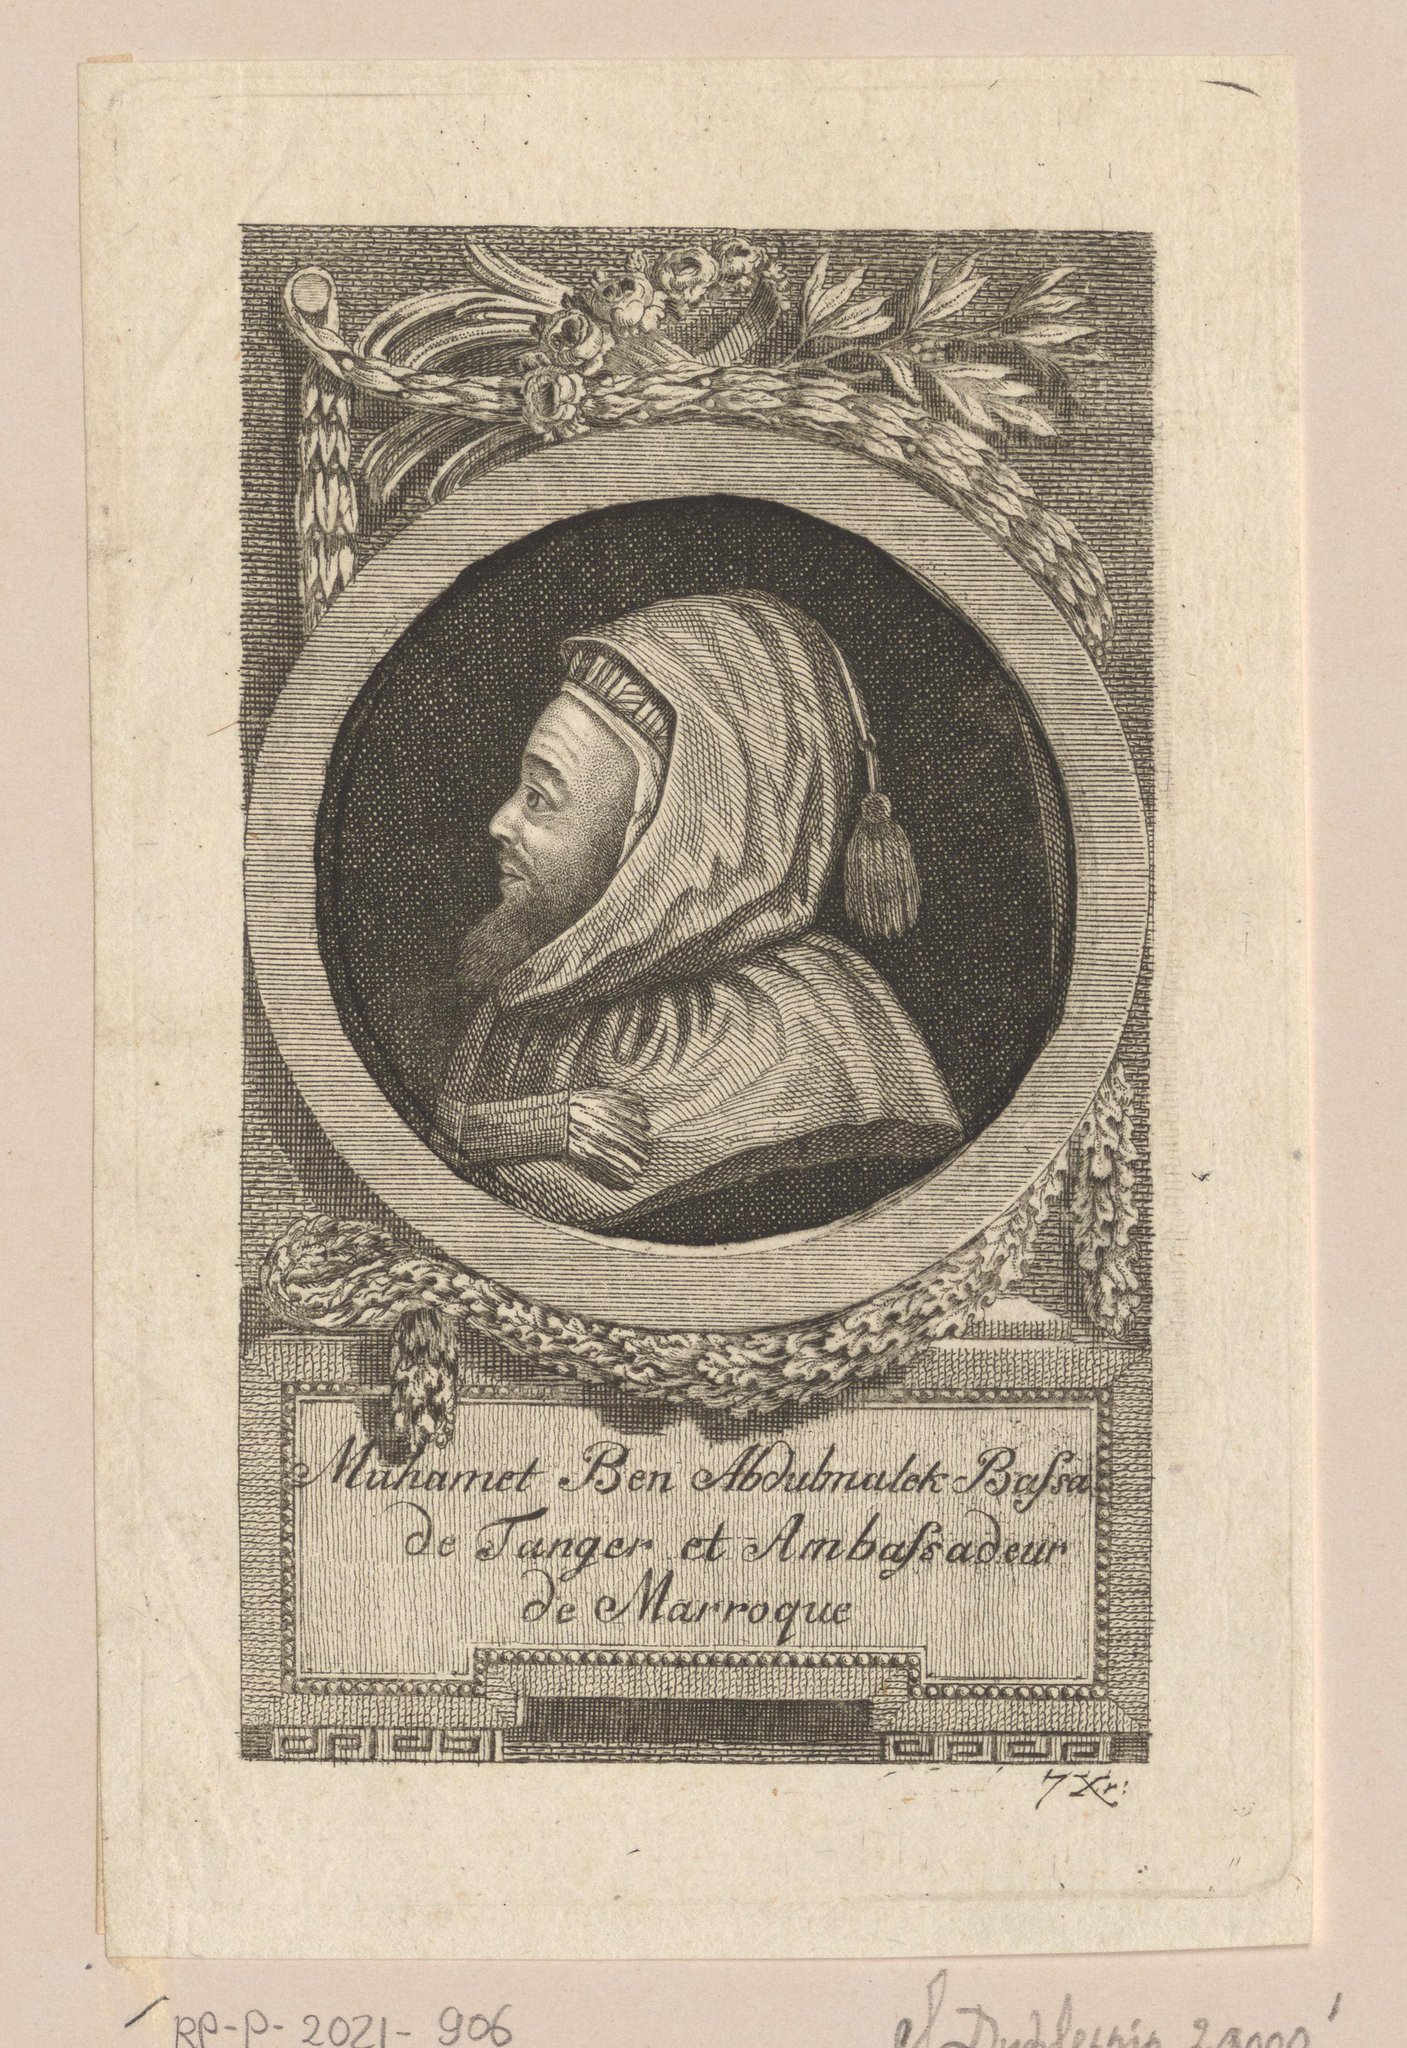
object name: print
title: Portret van Mohammed Ben Abdelmalik, pasja van Tanger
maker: Anonymous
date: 1783-1850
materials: paper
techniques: engraving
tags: historical persons, diplomacy, diplomat